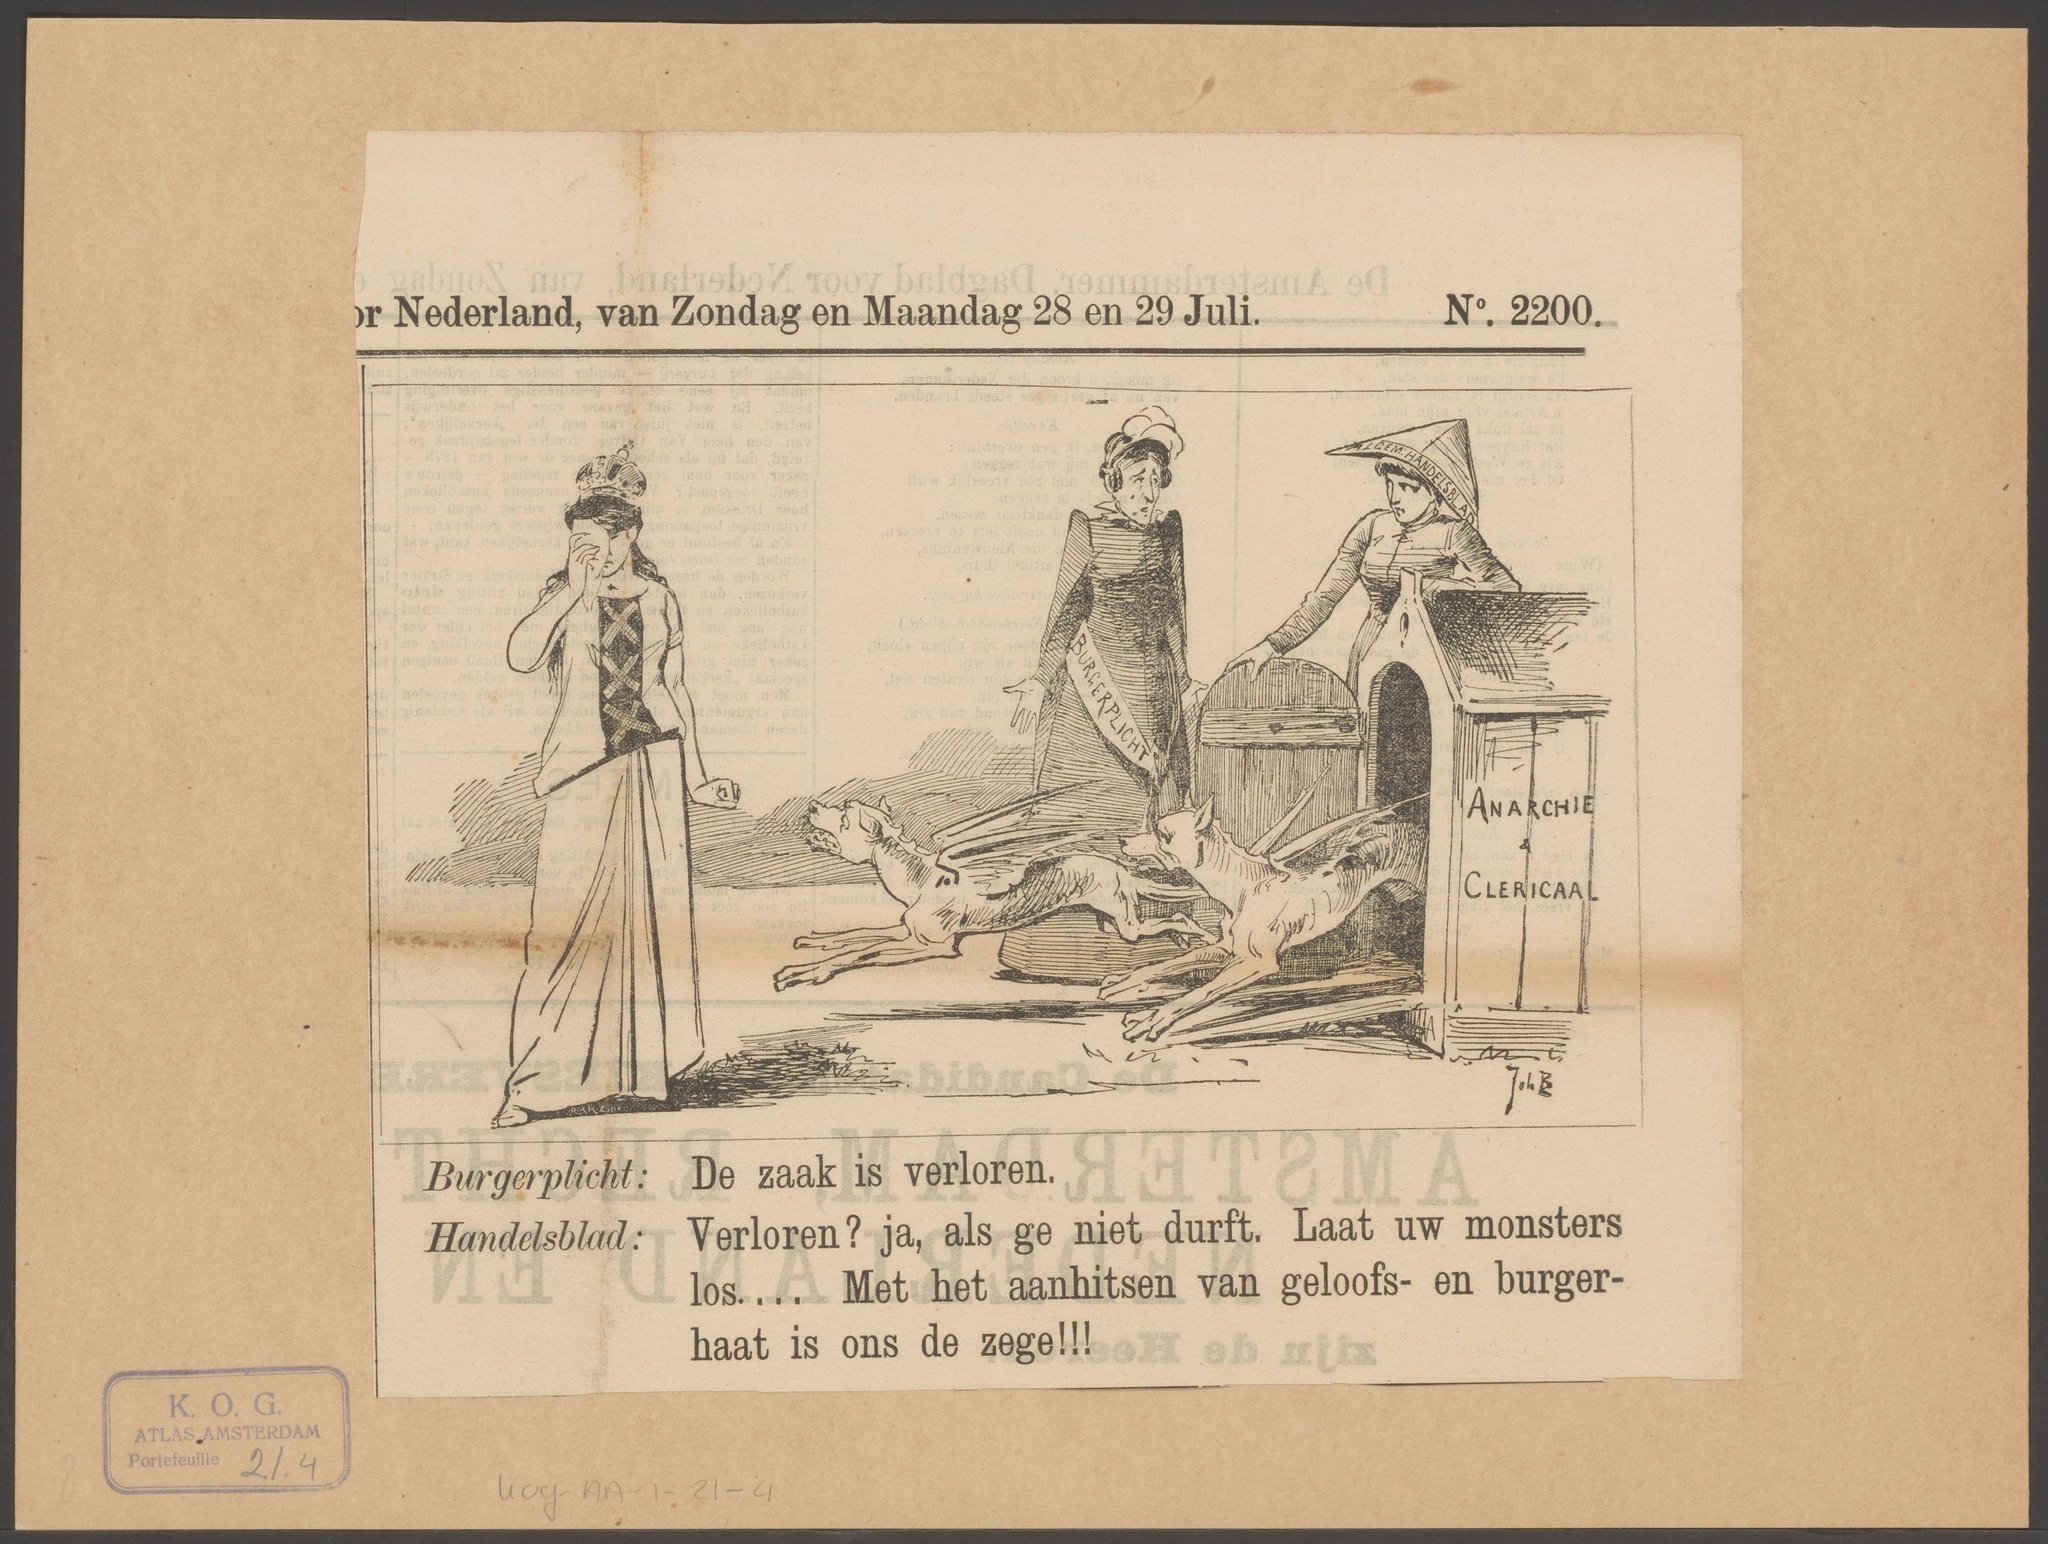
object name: cartoon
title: Twee vrouwen laten twee honden met vleugels afstormen op een huilende Amsterdamse stedenmaagd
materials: paper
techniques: letterpress printing, line block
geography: netherlands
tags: personification of a city, town-patron(ess), political caricatures and satires, amsterdam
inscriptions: collector's mark: Lugt 1641b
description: Prent uit: De Amsterdammer, [28 juli 1889, 28 juli 1895, 28 juli 1901, 28 juli 1907 of 28 juli 1912].